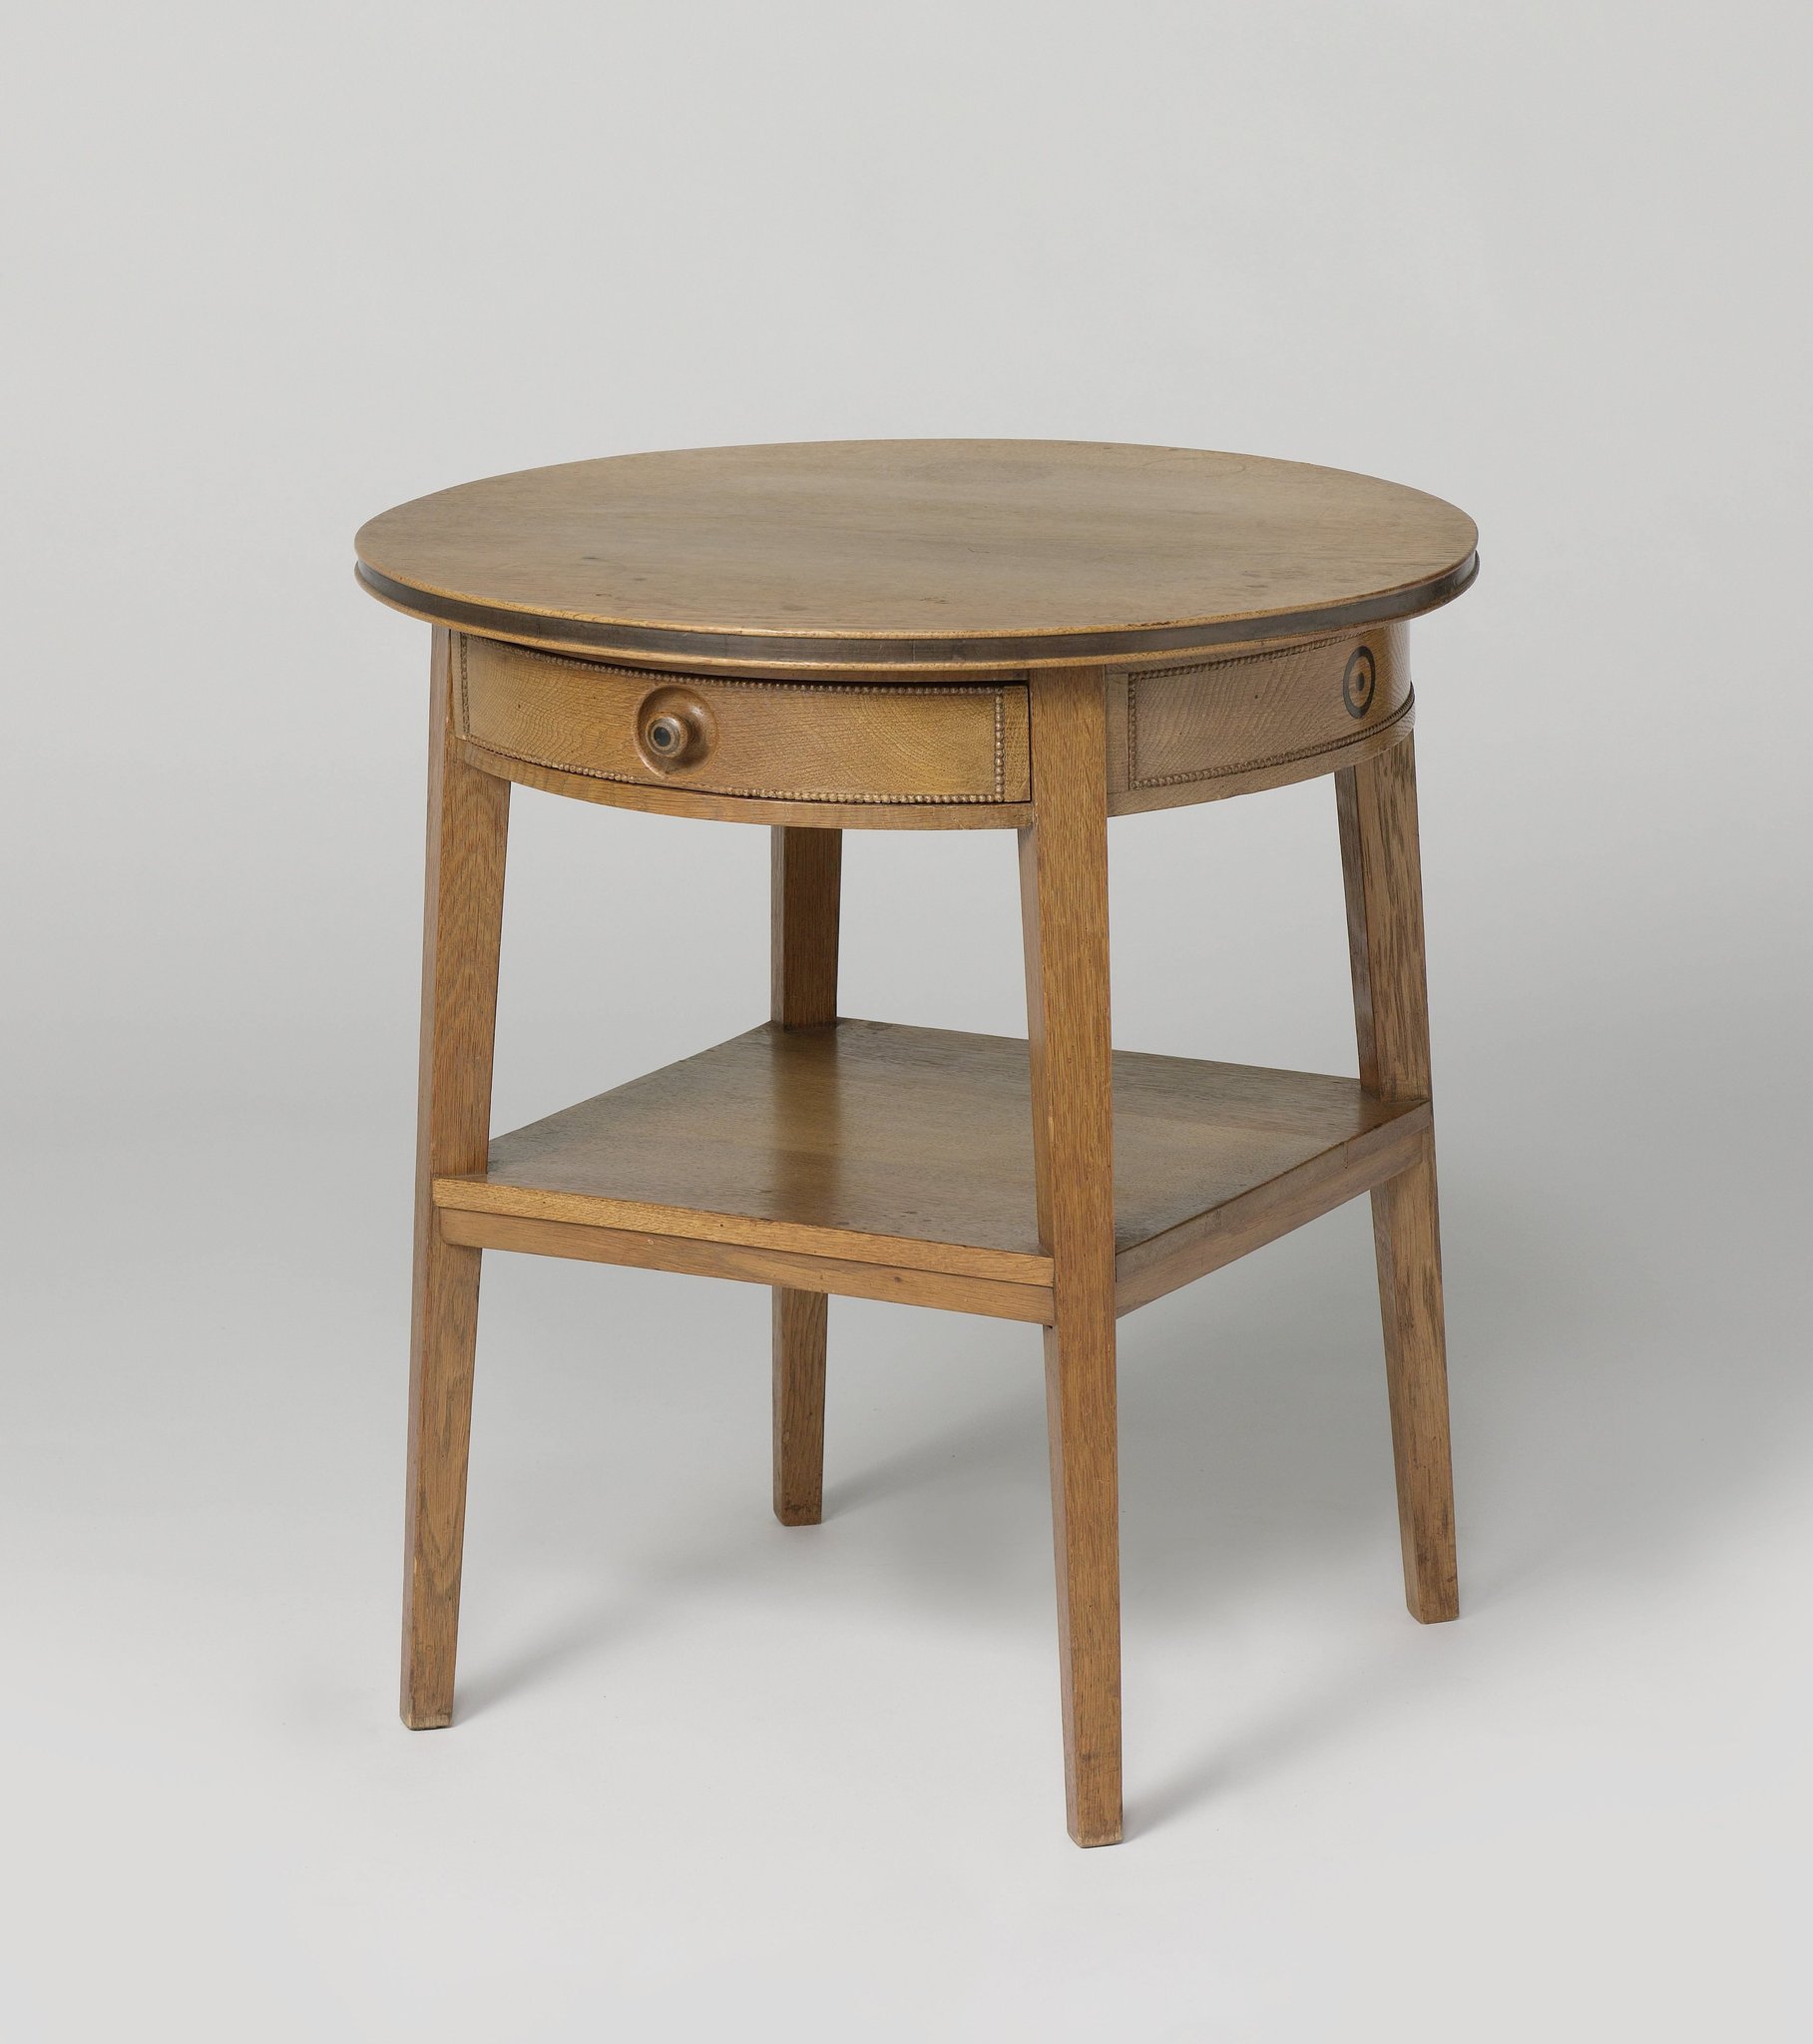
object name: table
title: Tafel met tussenblad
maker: karel petrus cornelis de bazel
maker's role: draughtsman, print maker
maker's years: 1869-1923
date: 1894-1900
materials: wood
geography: amsterdam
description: Tafel van eikenhout rustend op vier schuingestelde poten. Halverwege tussen de poten bevindt zich een vierkant tafelblad. Aan de bovenzijde worden de poten onderling verbonden door gebogen regels waarin zich vier laden bevinden. De laden hebben langs de randen een parelrand en zijn in het midden voorzien van een gesneden knop ingelegd met ebbenhout. Daarop rust het ronde tafelblad met een geprofileerde rand.